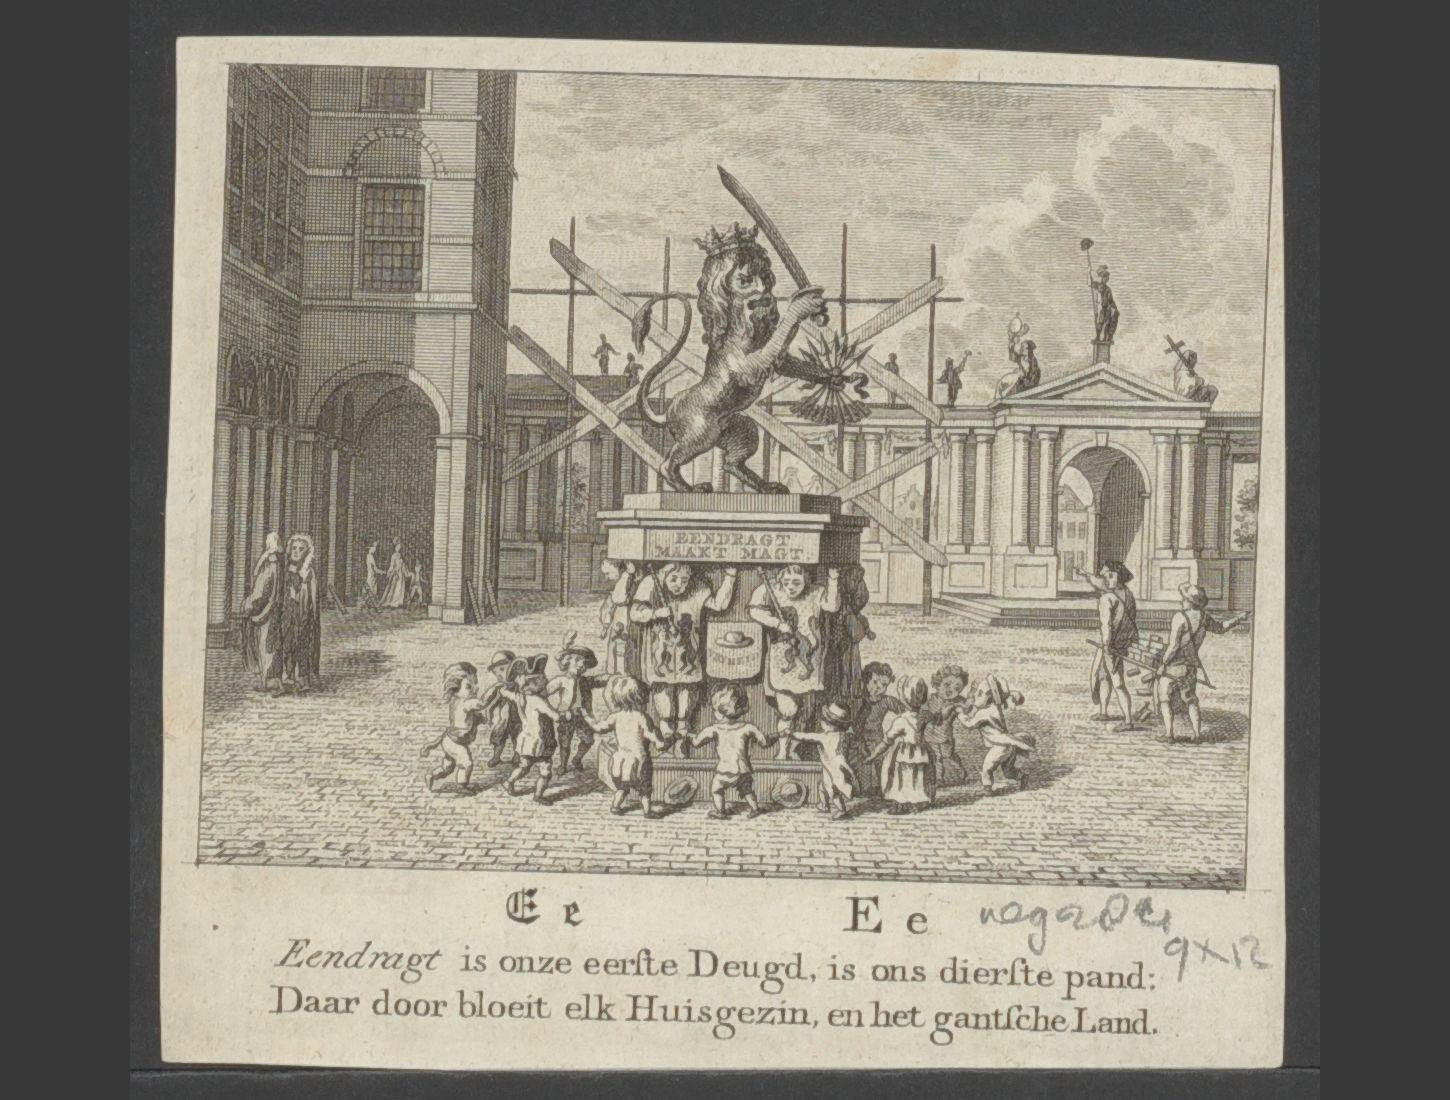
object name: book illustration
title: Beeld van een leeuw met zwaard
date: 1781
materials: paper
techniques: engraving, etching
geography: amsterdam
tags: concord, 'concordia' ~ one of the seven gifts of the soul, ring and square dancing (children's games), letters, alphabet, script, beasts of prey, predatory animals: lion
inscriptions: stamp, collector's mark: Lugt 1641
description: Beeld van een leeuw met zwaard. Op de sokkel de tekst: Eendragt maakt magt. Om het beeld dansen kinderen hand in hand. Onder de voorstelling de letter E in twee verschillende lettertypes. Onderaan een tweeregelig vers over eendracht. Onderwerpsrubrieken binnen de Atlas Zeden en Gewoonten: Onderwijs en Wetenschappen, Opvoeding en Onderwijs, Haneboeken en schoolprenten.